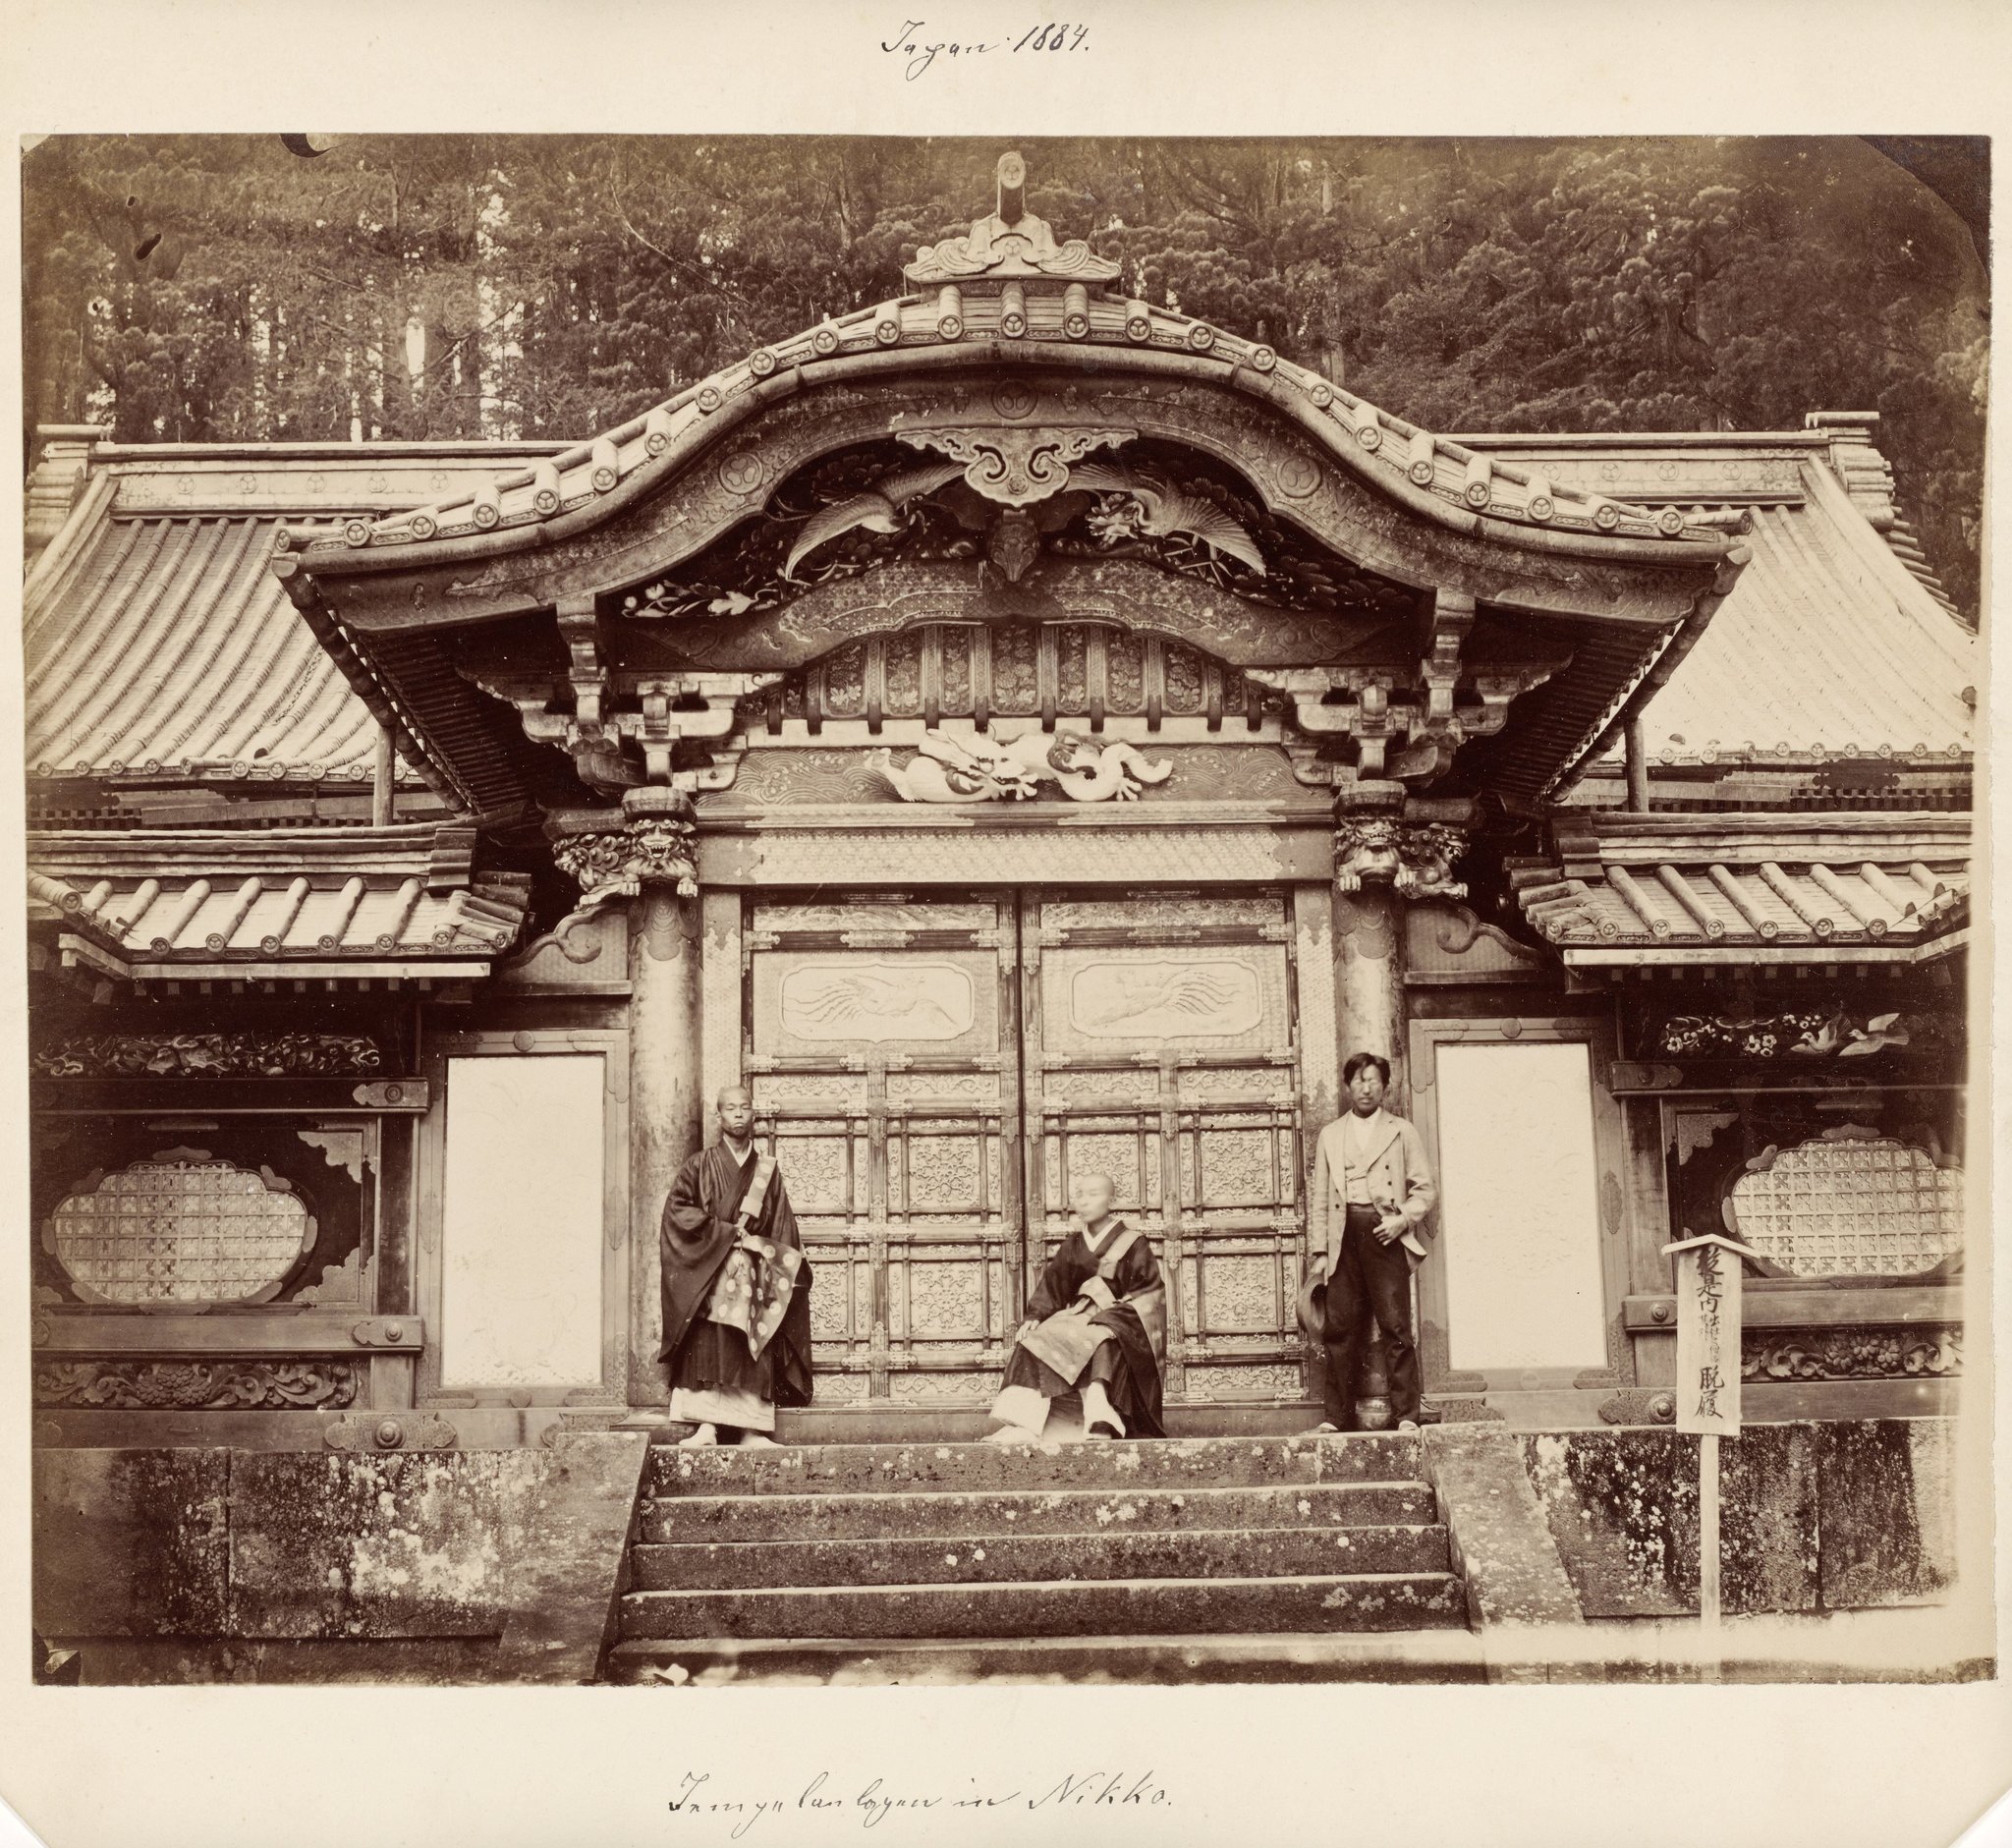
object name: photograph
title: Tempelanlagen von Nikko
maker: Anonymous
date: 1884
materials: cardboard, paper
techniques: albumen print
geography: nikkō tōshō-gū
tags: temple, shrine ~ shinto, monk(s), friar(s)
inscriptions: inscription: ‘Tempelanlagen von Nikko’